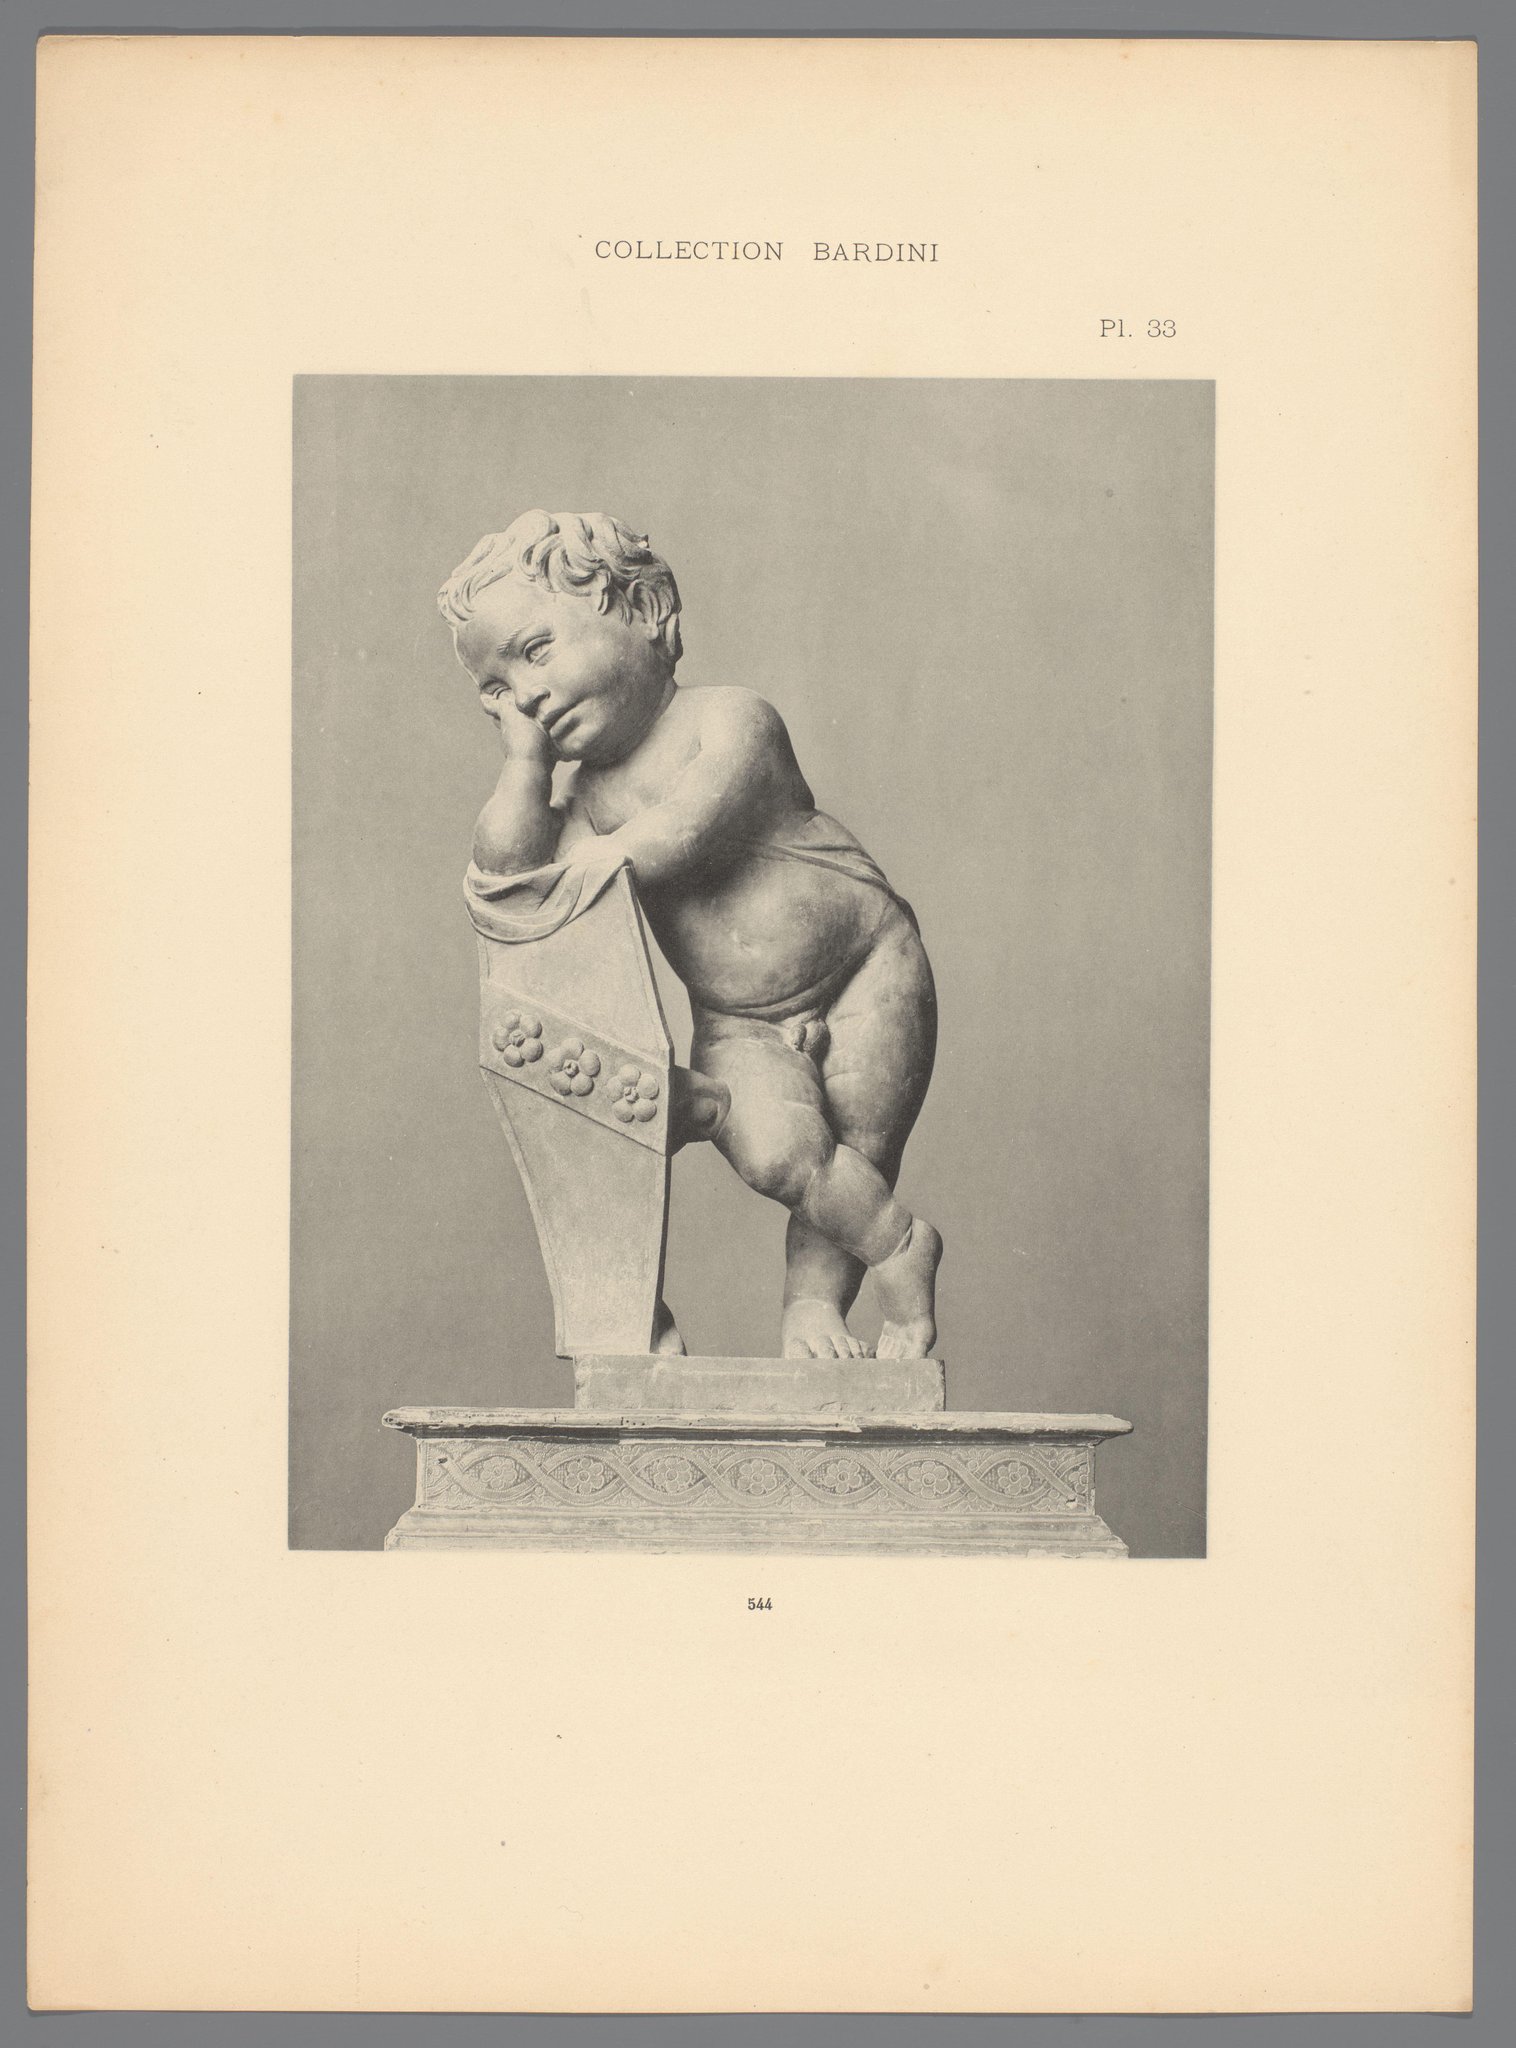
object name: photomechanical print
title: Collection Bardini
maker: Anonymous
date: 1875-1930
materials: paper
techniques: photograph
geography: florence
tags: protective weapons: shield, child, sculpture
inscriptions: number: ‘Pl. 33’